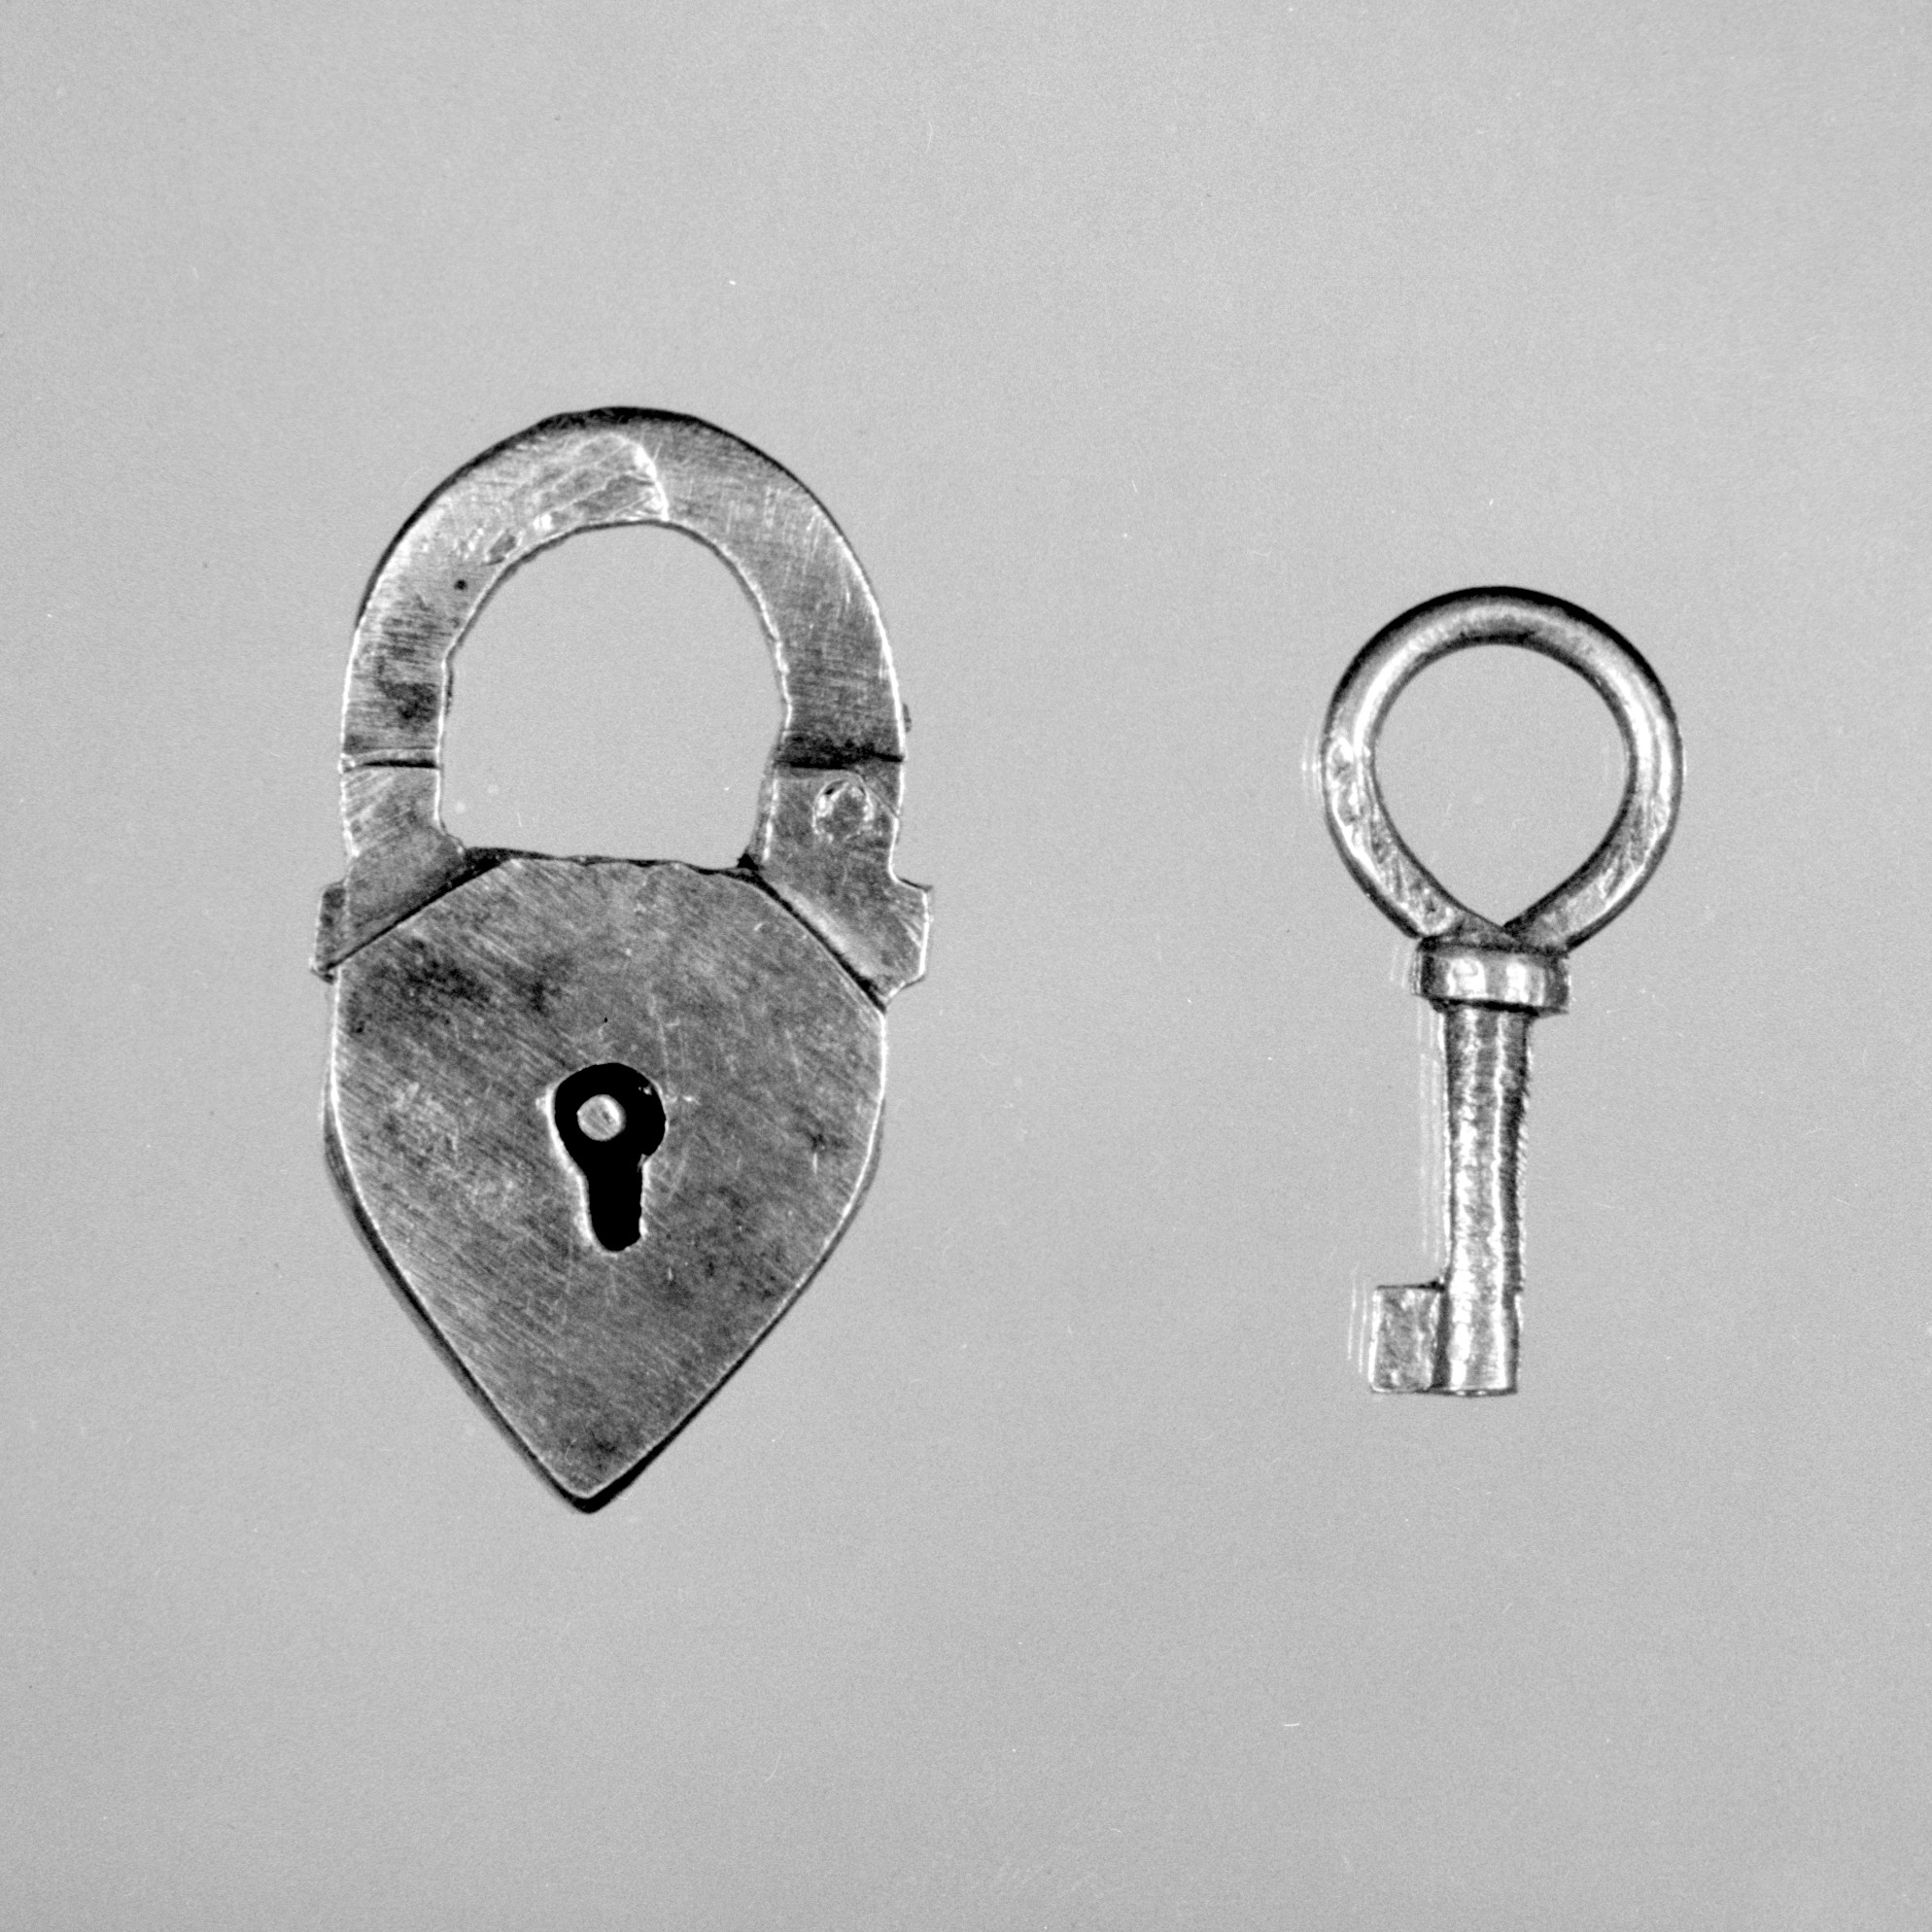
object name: padlock with key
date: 1801-1900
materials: steel